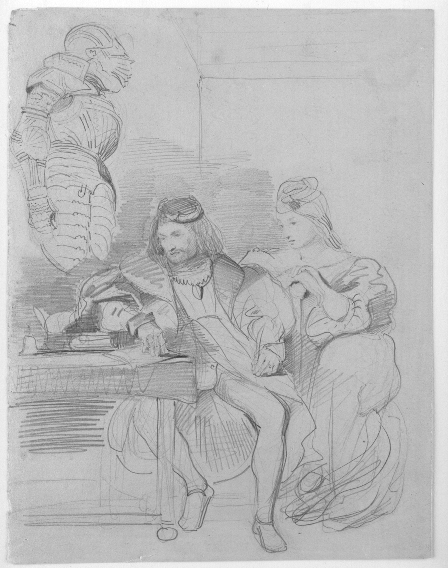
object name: drawing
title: Götz von Berlichingen Writing His Memoirs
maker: eugène delacroix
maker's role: artist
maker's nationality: french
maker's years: 1798-1863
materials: graphite, paper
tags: armor,men,women